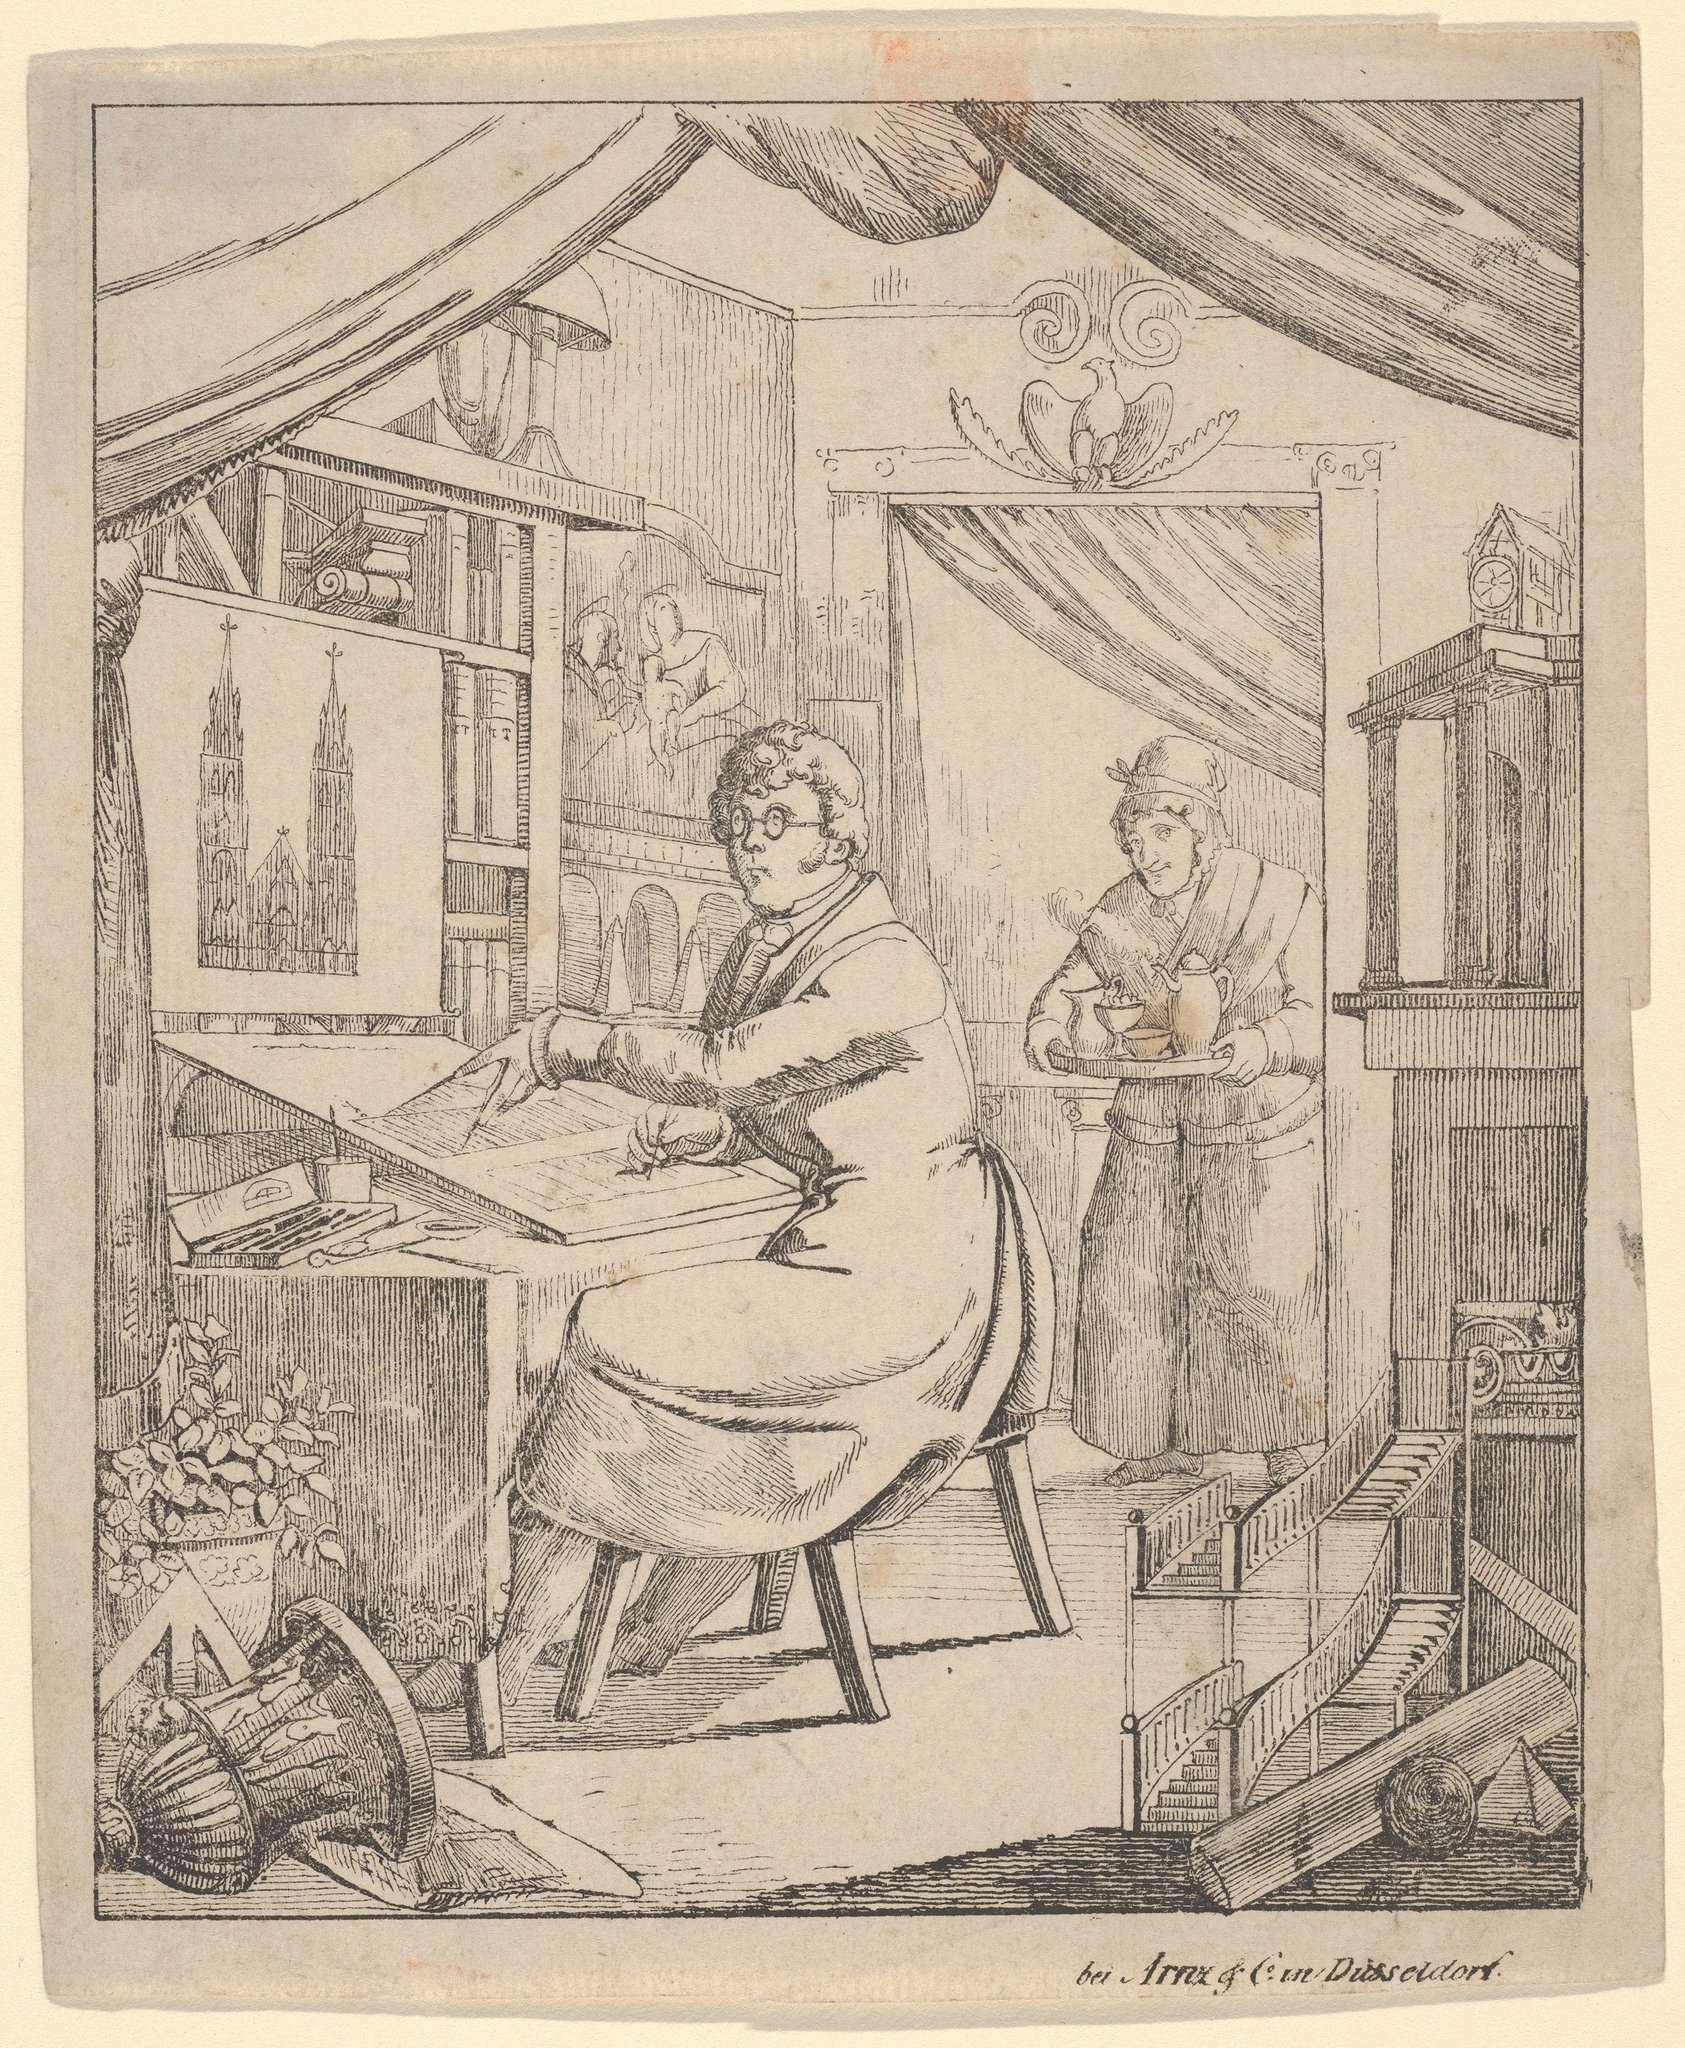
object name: print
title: An Architect in His Studio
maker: anonymous, german, 19th century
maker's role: artist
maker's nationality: german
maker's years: 1800-1899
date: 1790-1850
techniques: lithograph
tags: interiors,men,working,architects